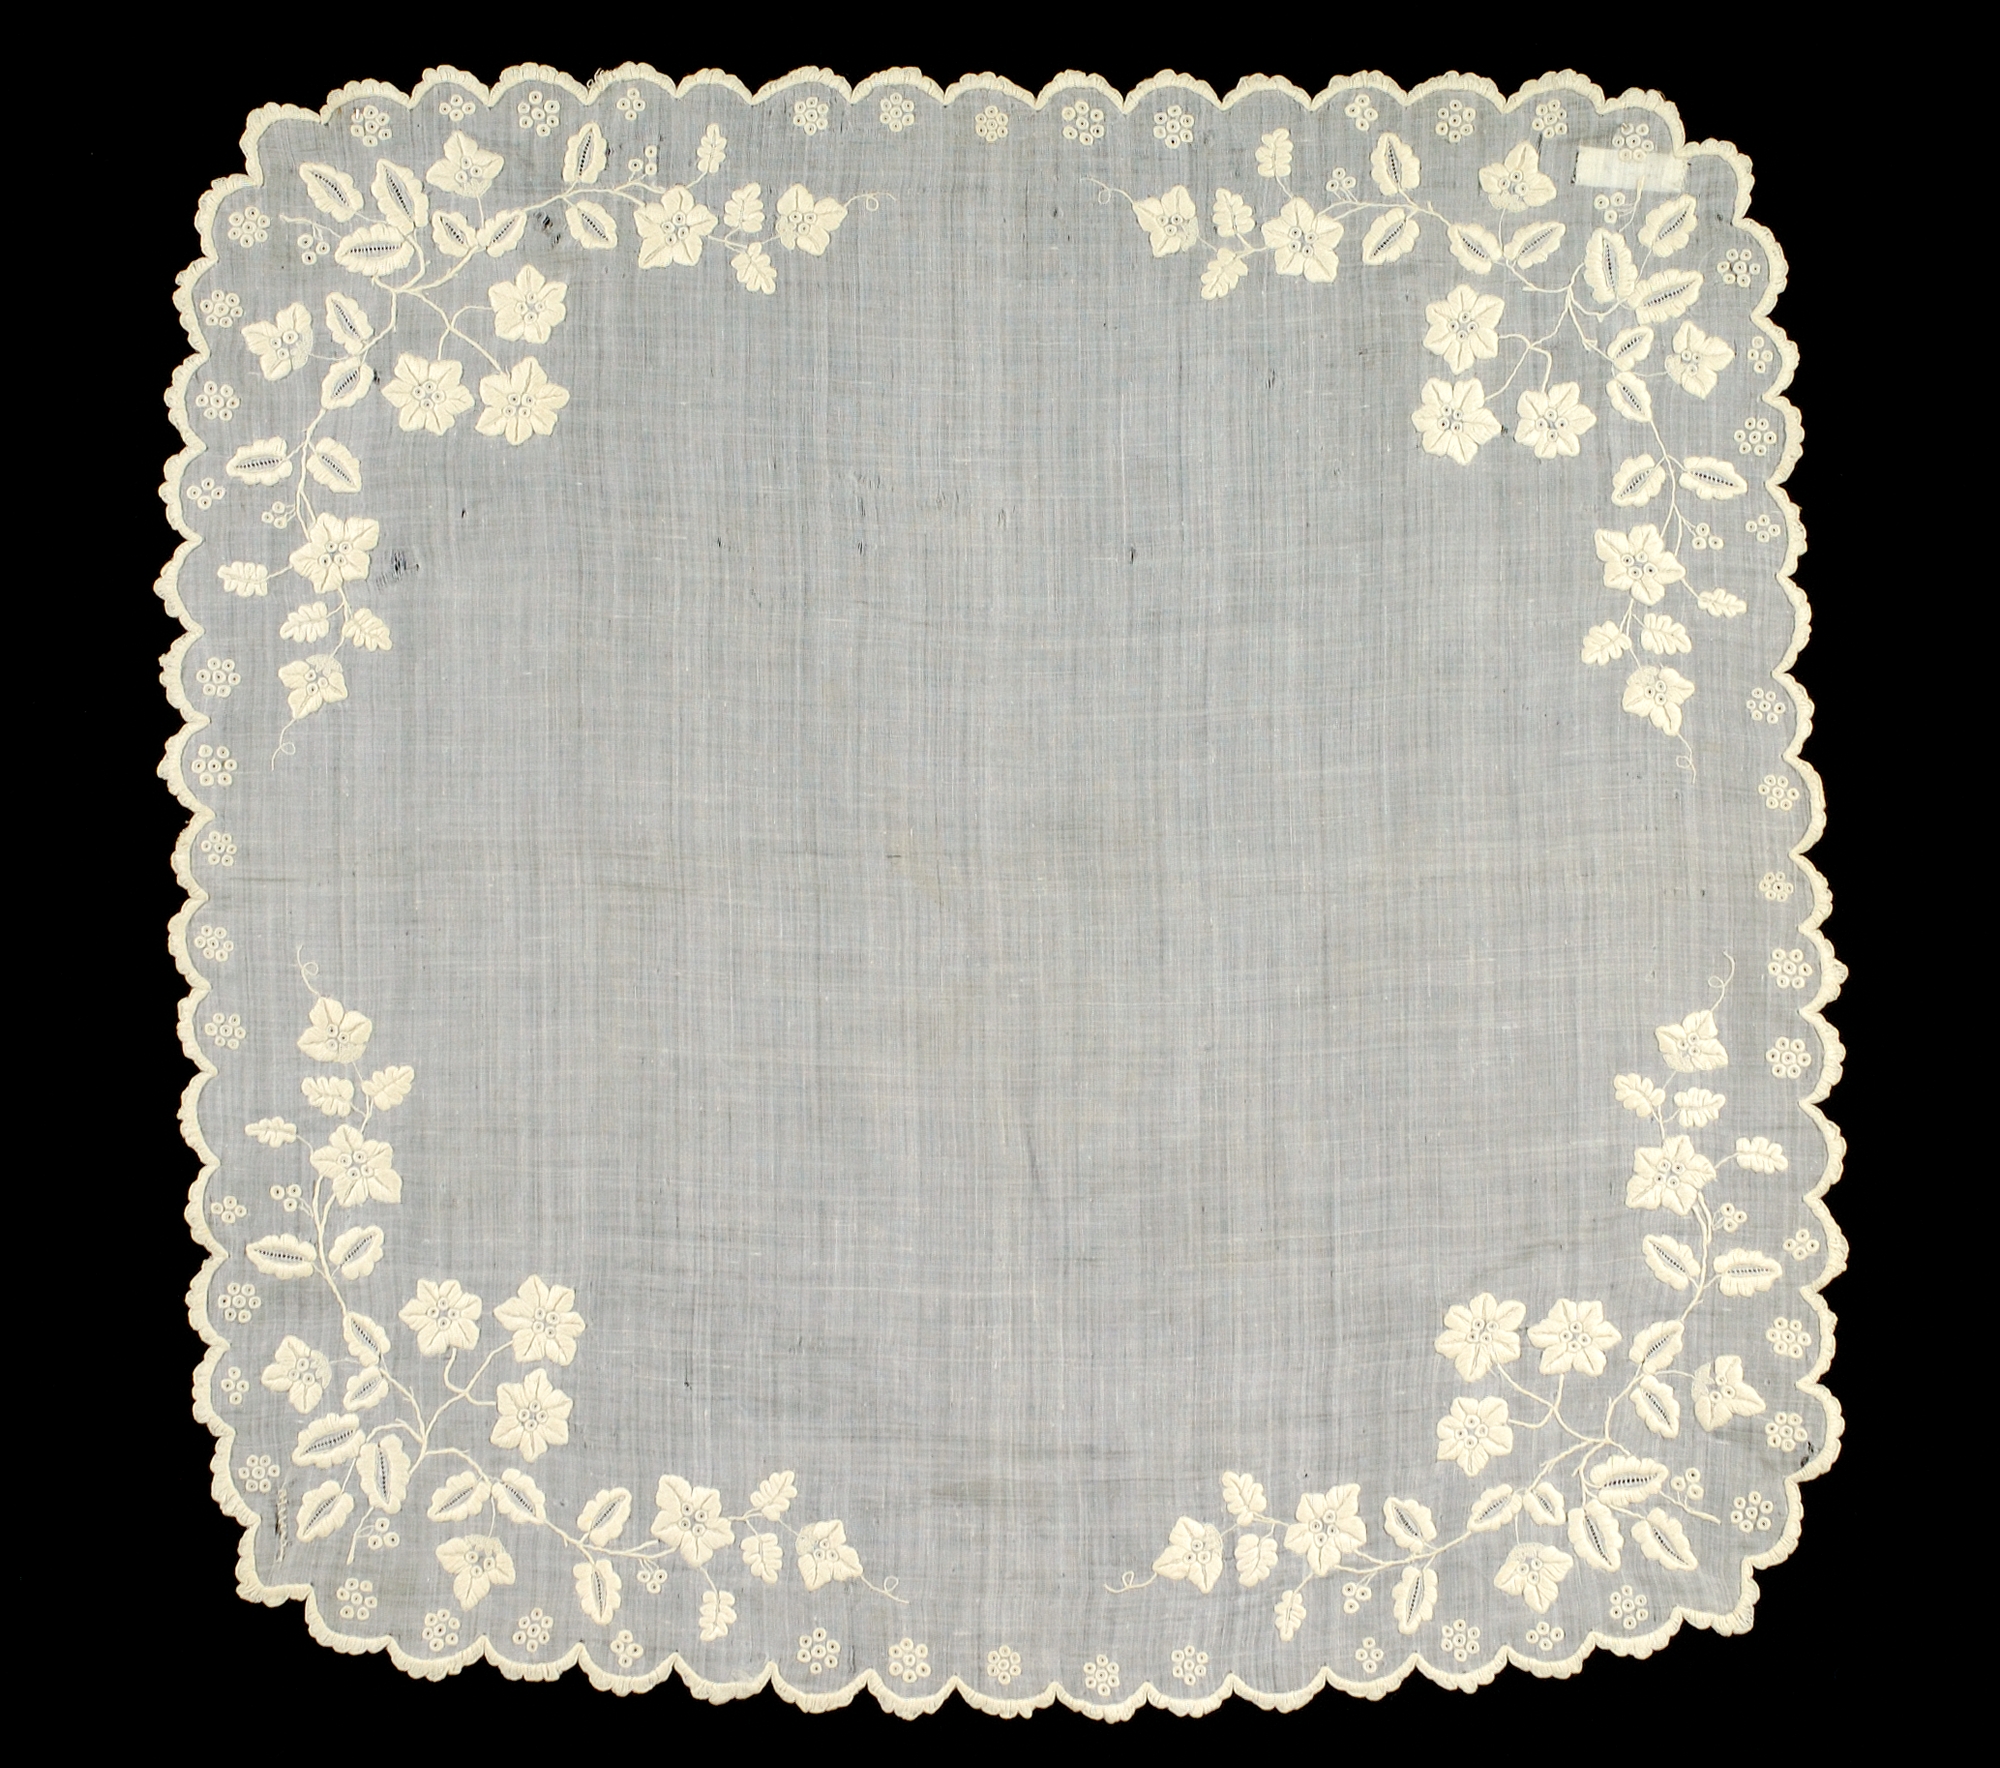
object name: handkerchief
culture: french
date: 1850-1860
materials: linen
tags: flowers